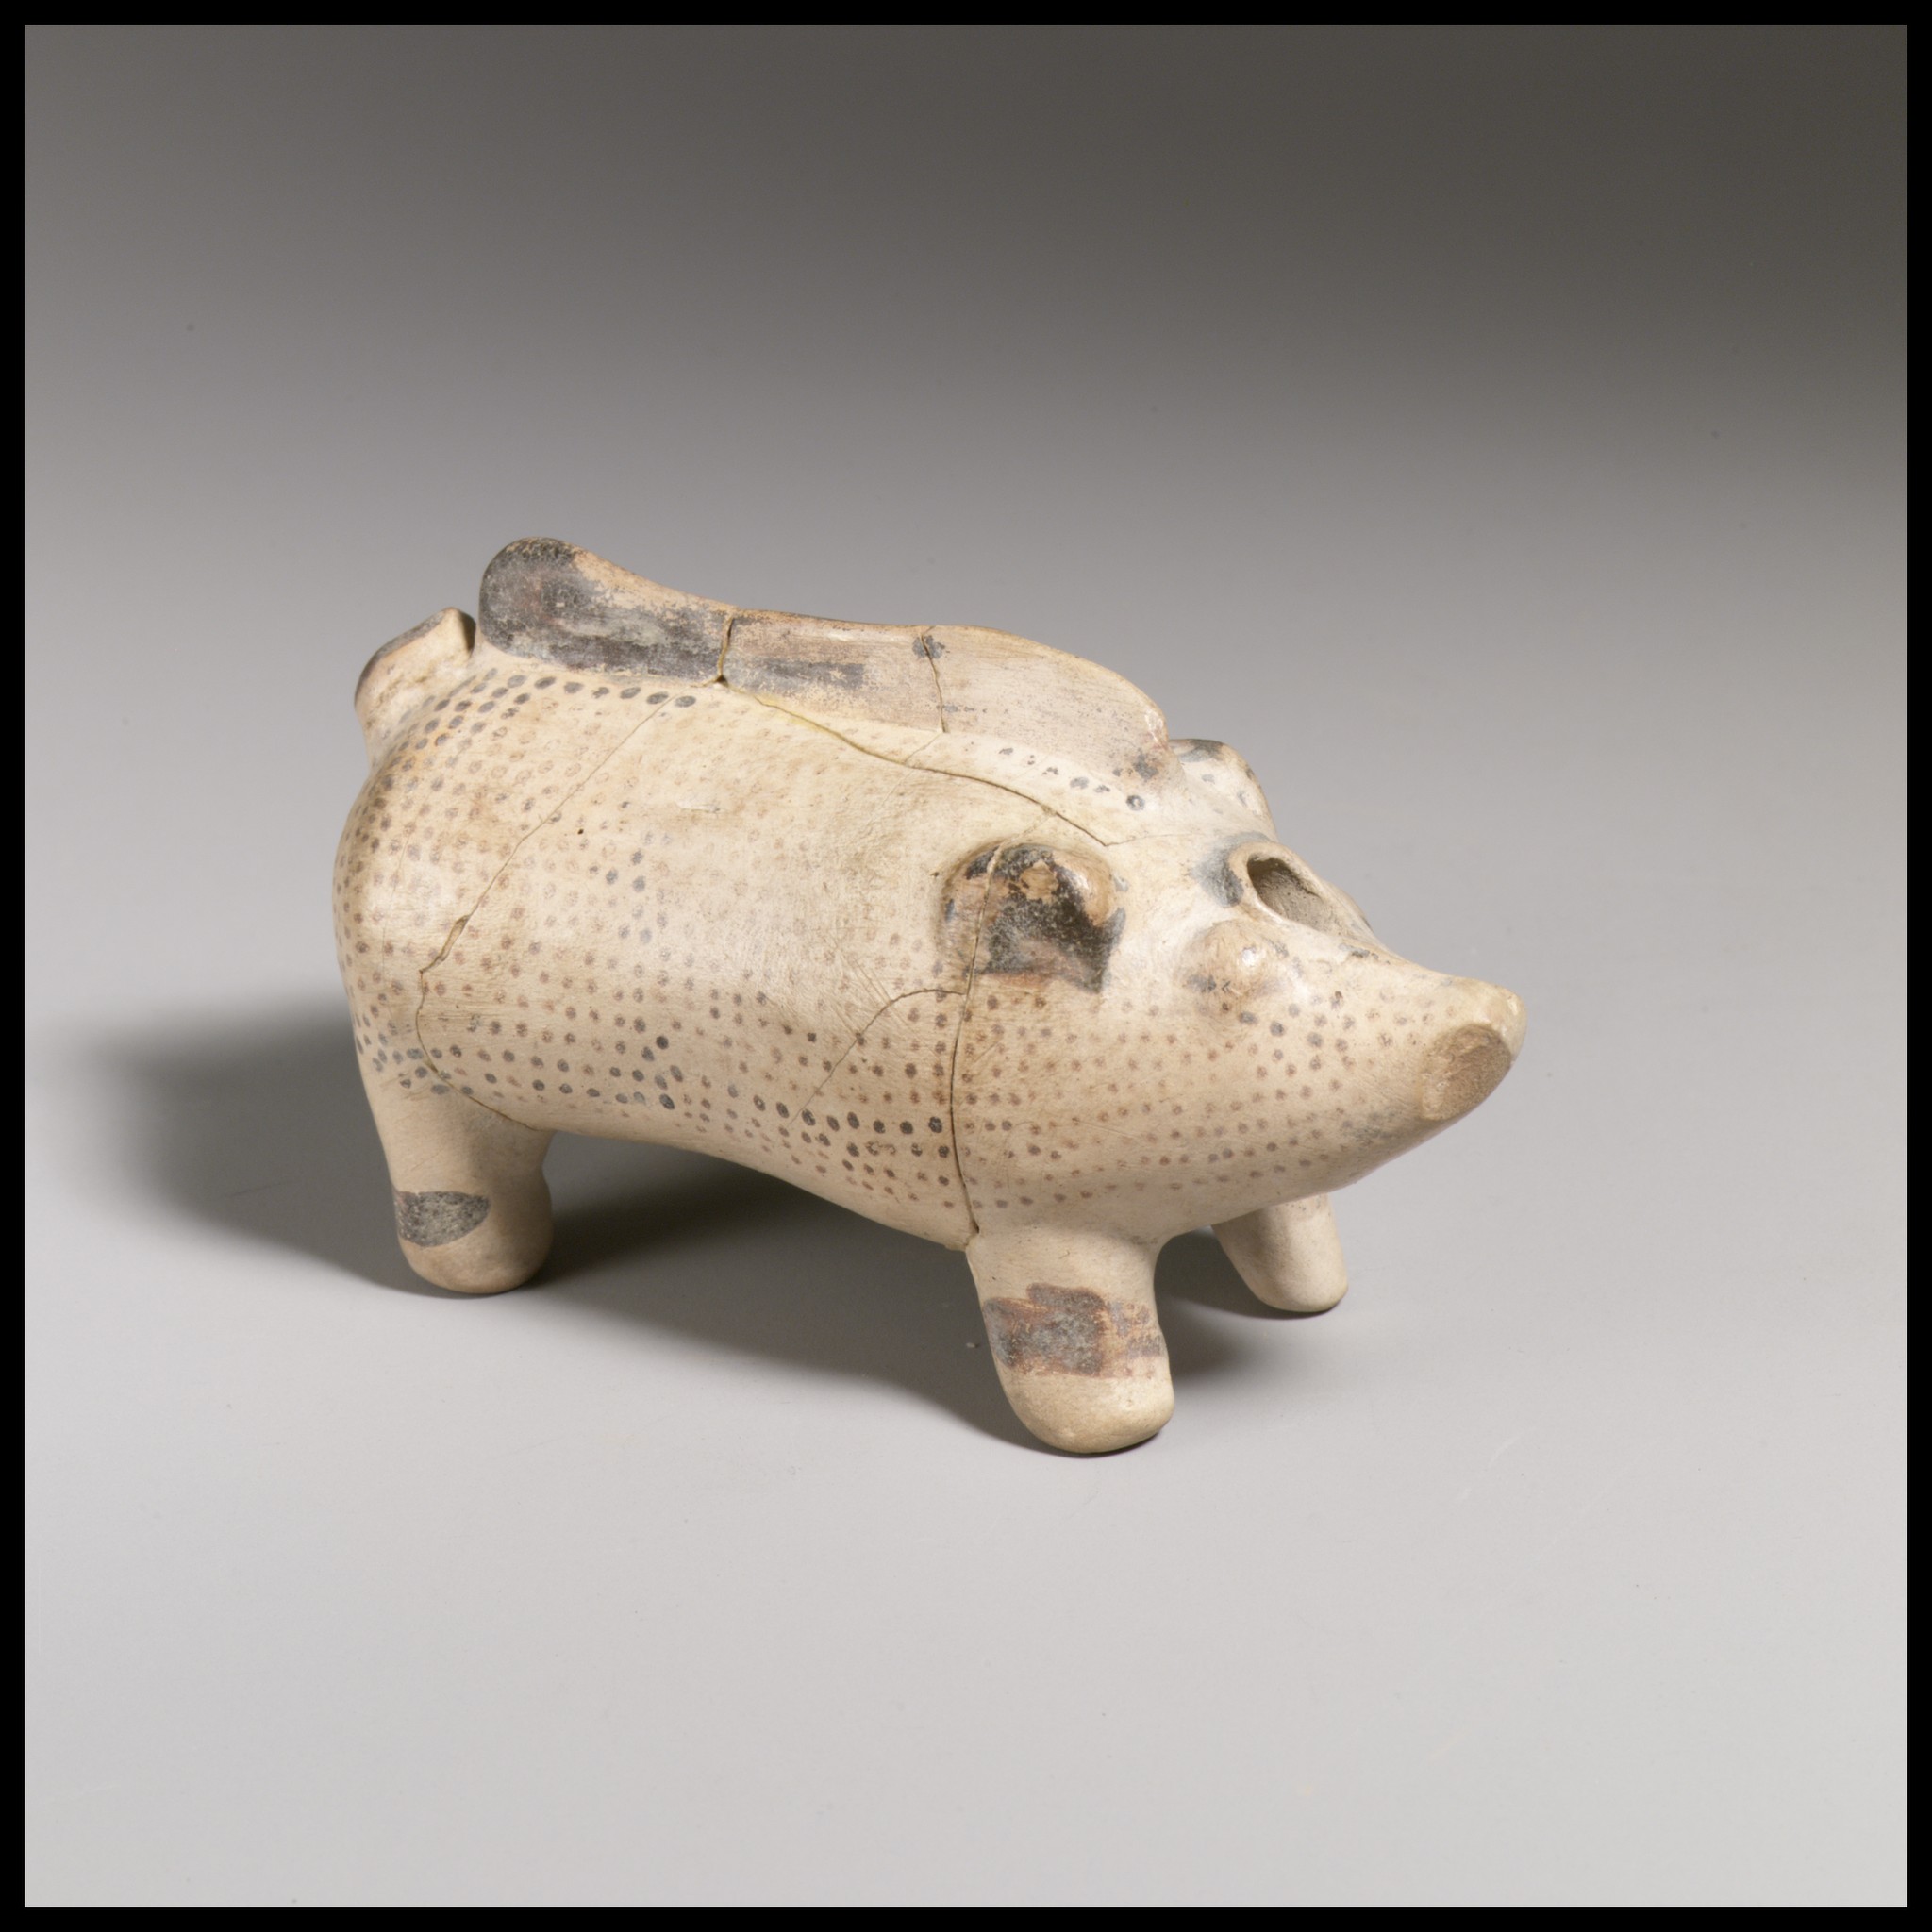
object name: vase in the form of a pig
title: Terracotta vase in the form of a pig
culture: greek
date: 600-501 BCE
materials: terracotta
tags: pigs